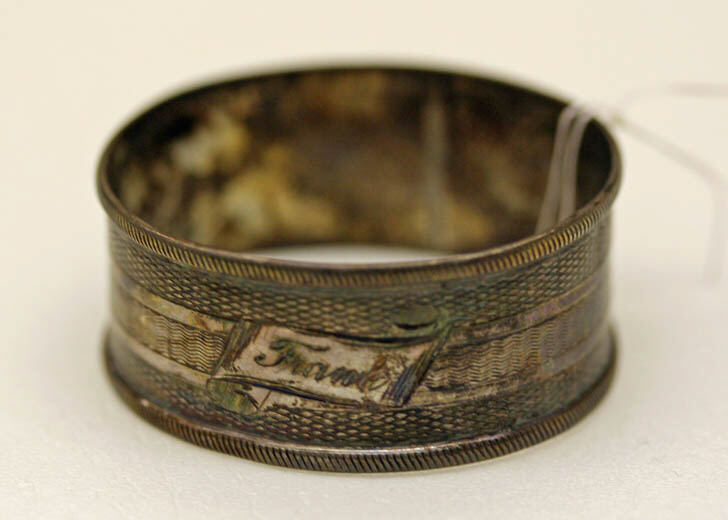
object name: accessory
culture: american or european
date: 1857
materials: silver